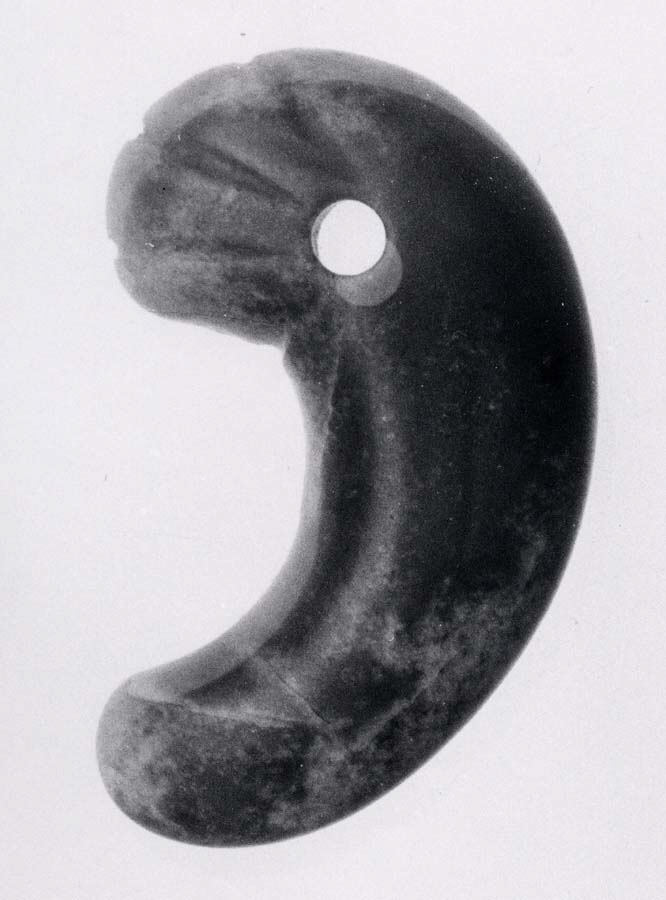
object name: ornament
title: Comma-shaped ornament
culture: korean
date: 501-600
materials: jade, silver